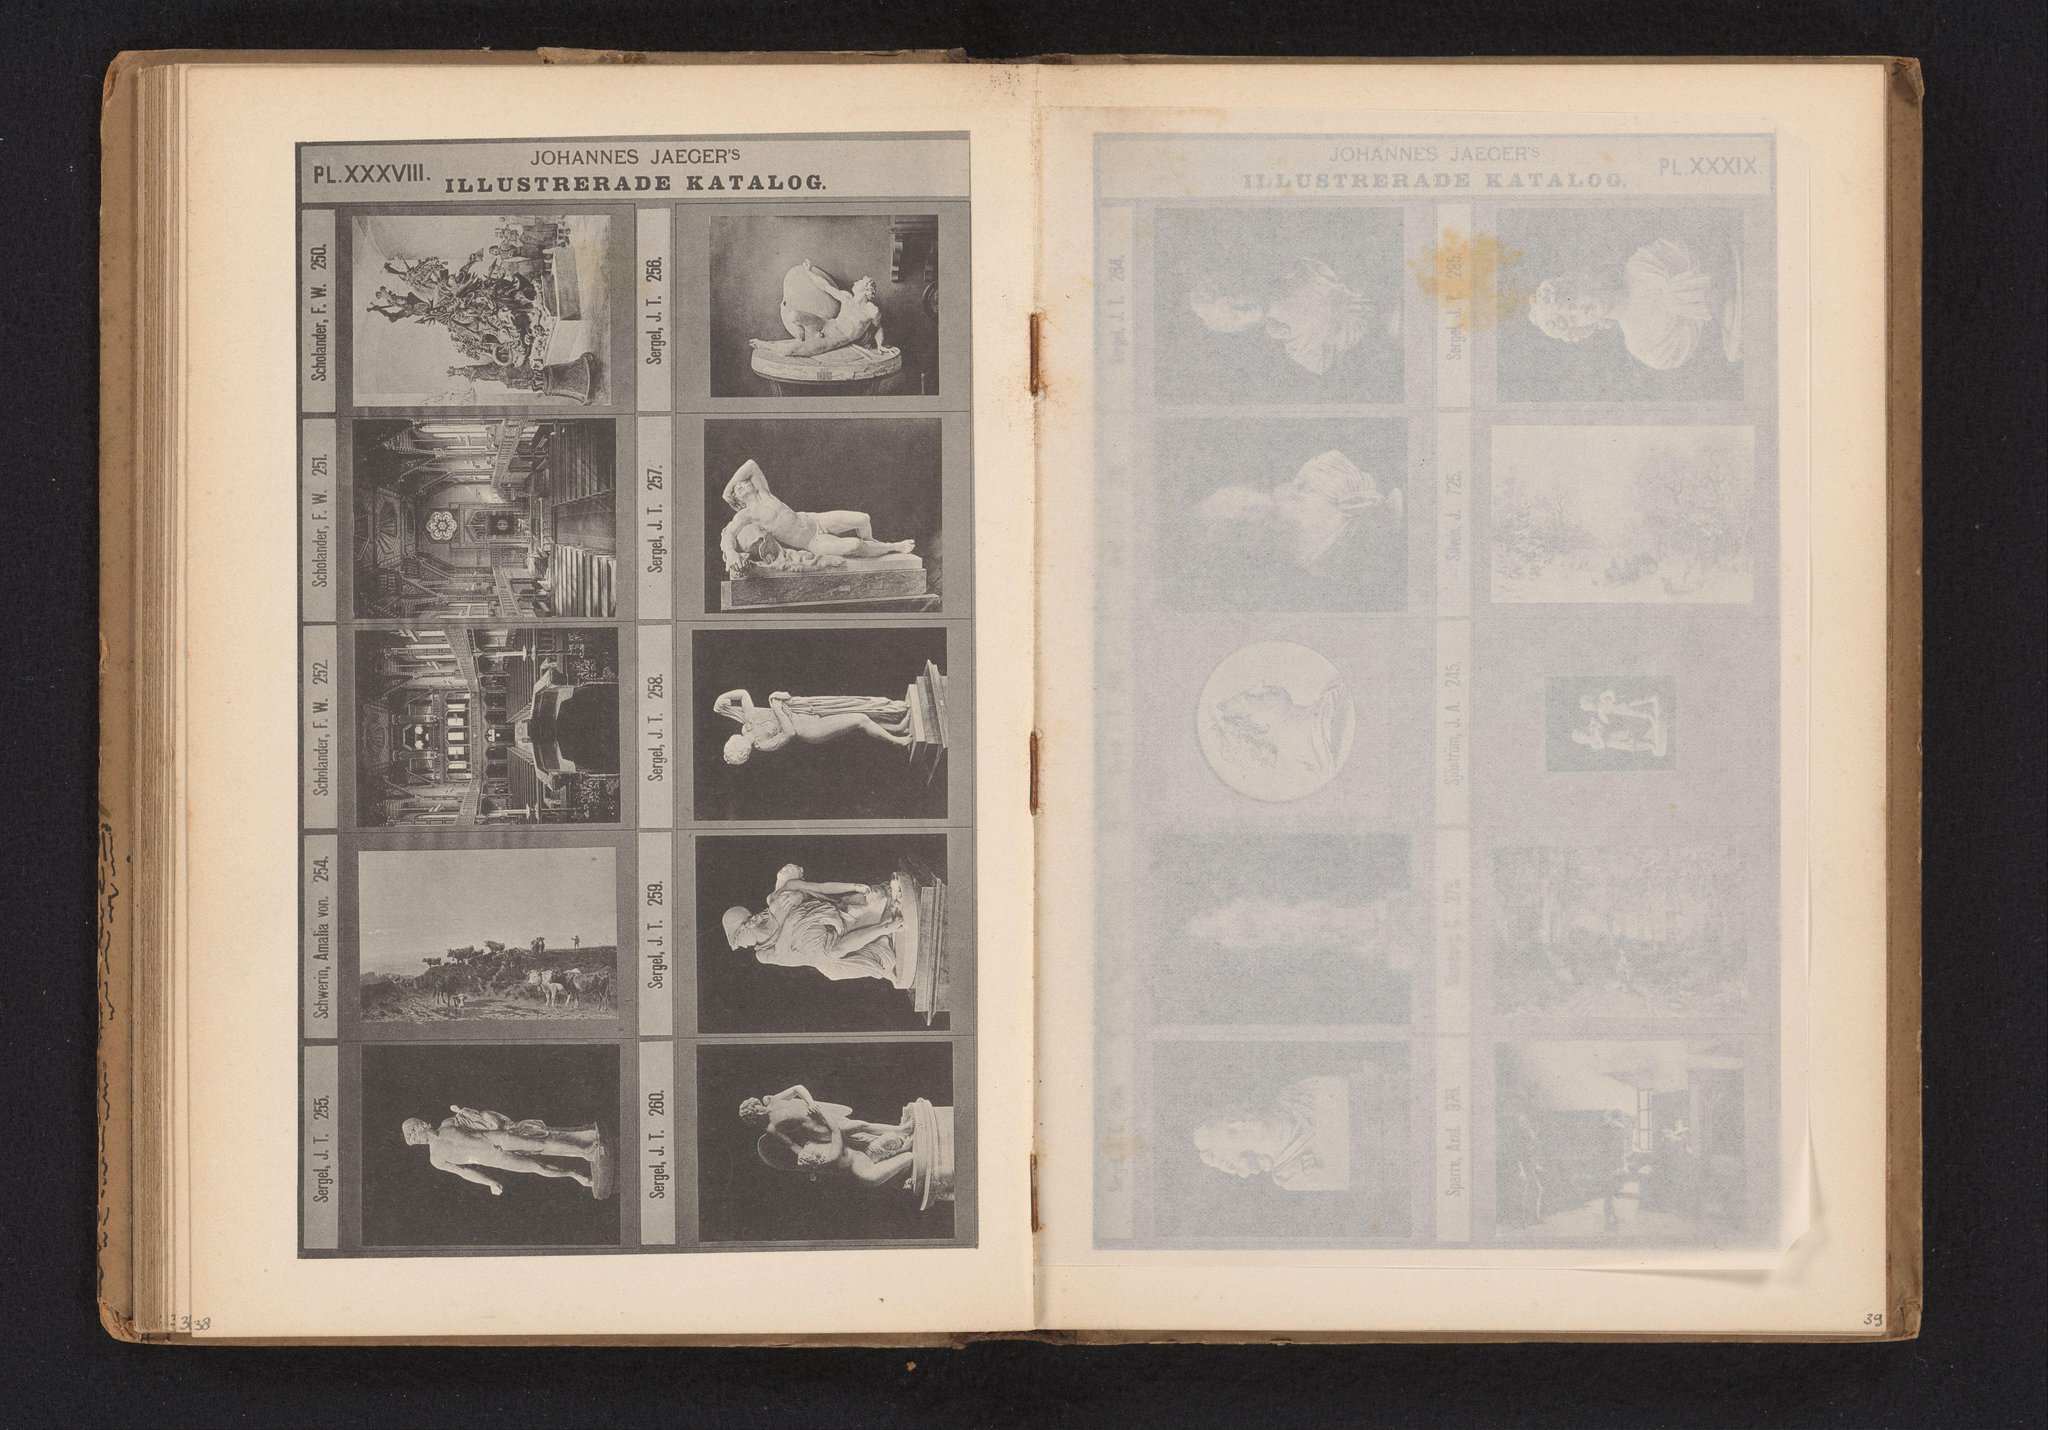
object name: reproduction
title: Johannes Jaeger's Illustrerade Katalog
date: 1872-1882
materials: paper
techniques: photograph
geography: stockholm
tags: sculpture, picture, painting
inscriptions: number: ‘PL. XXXVIII.’